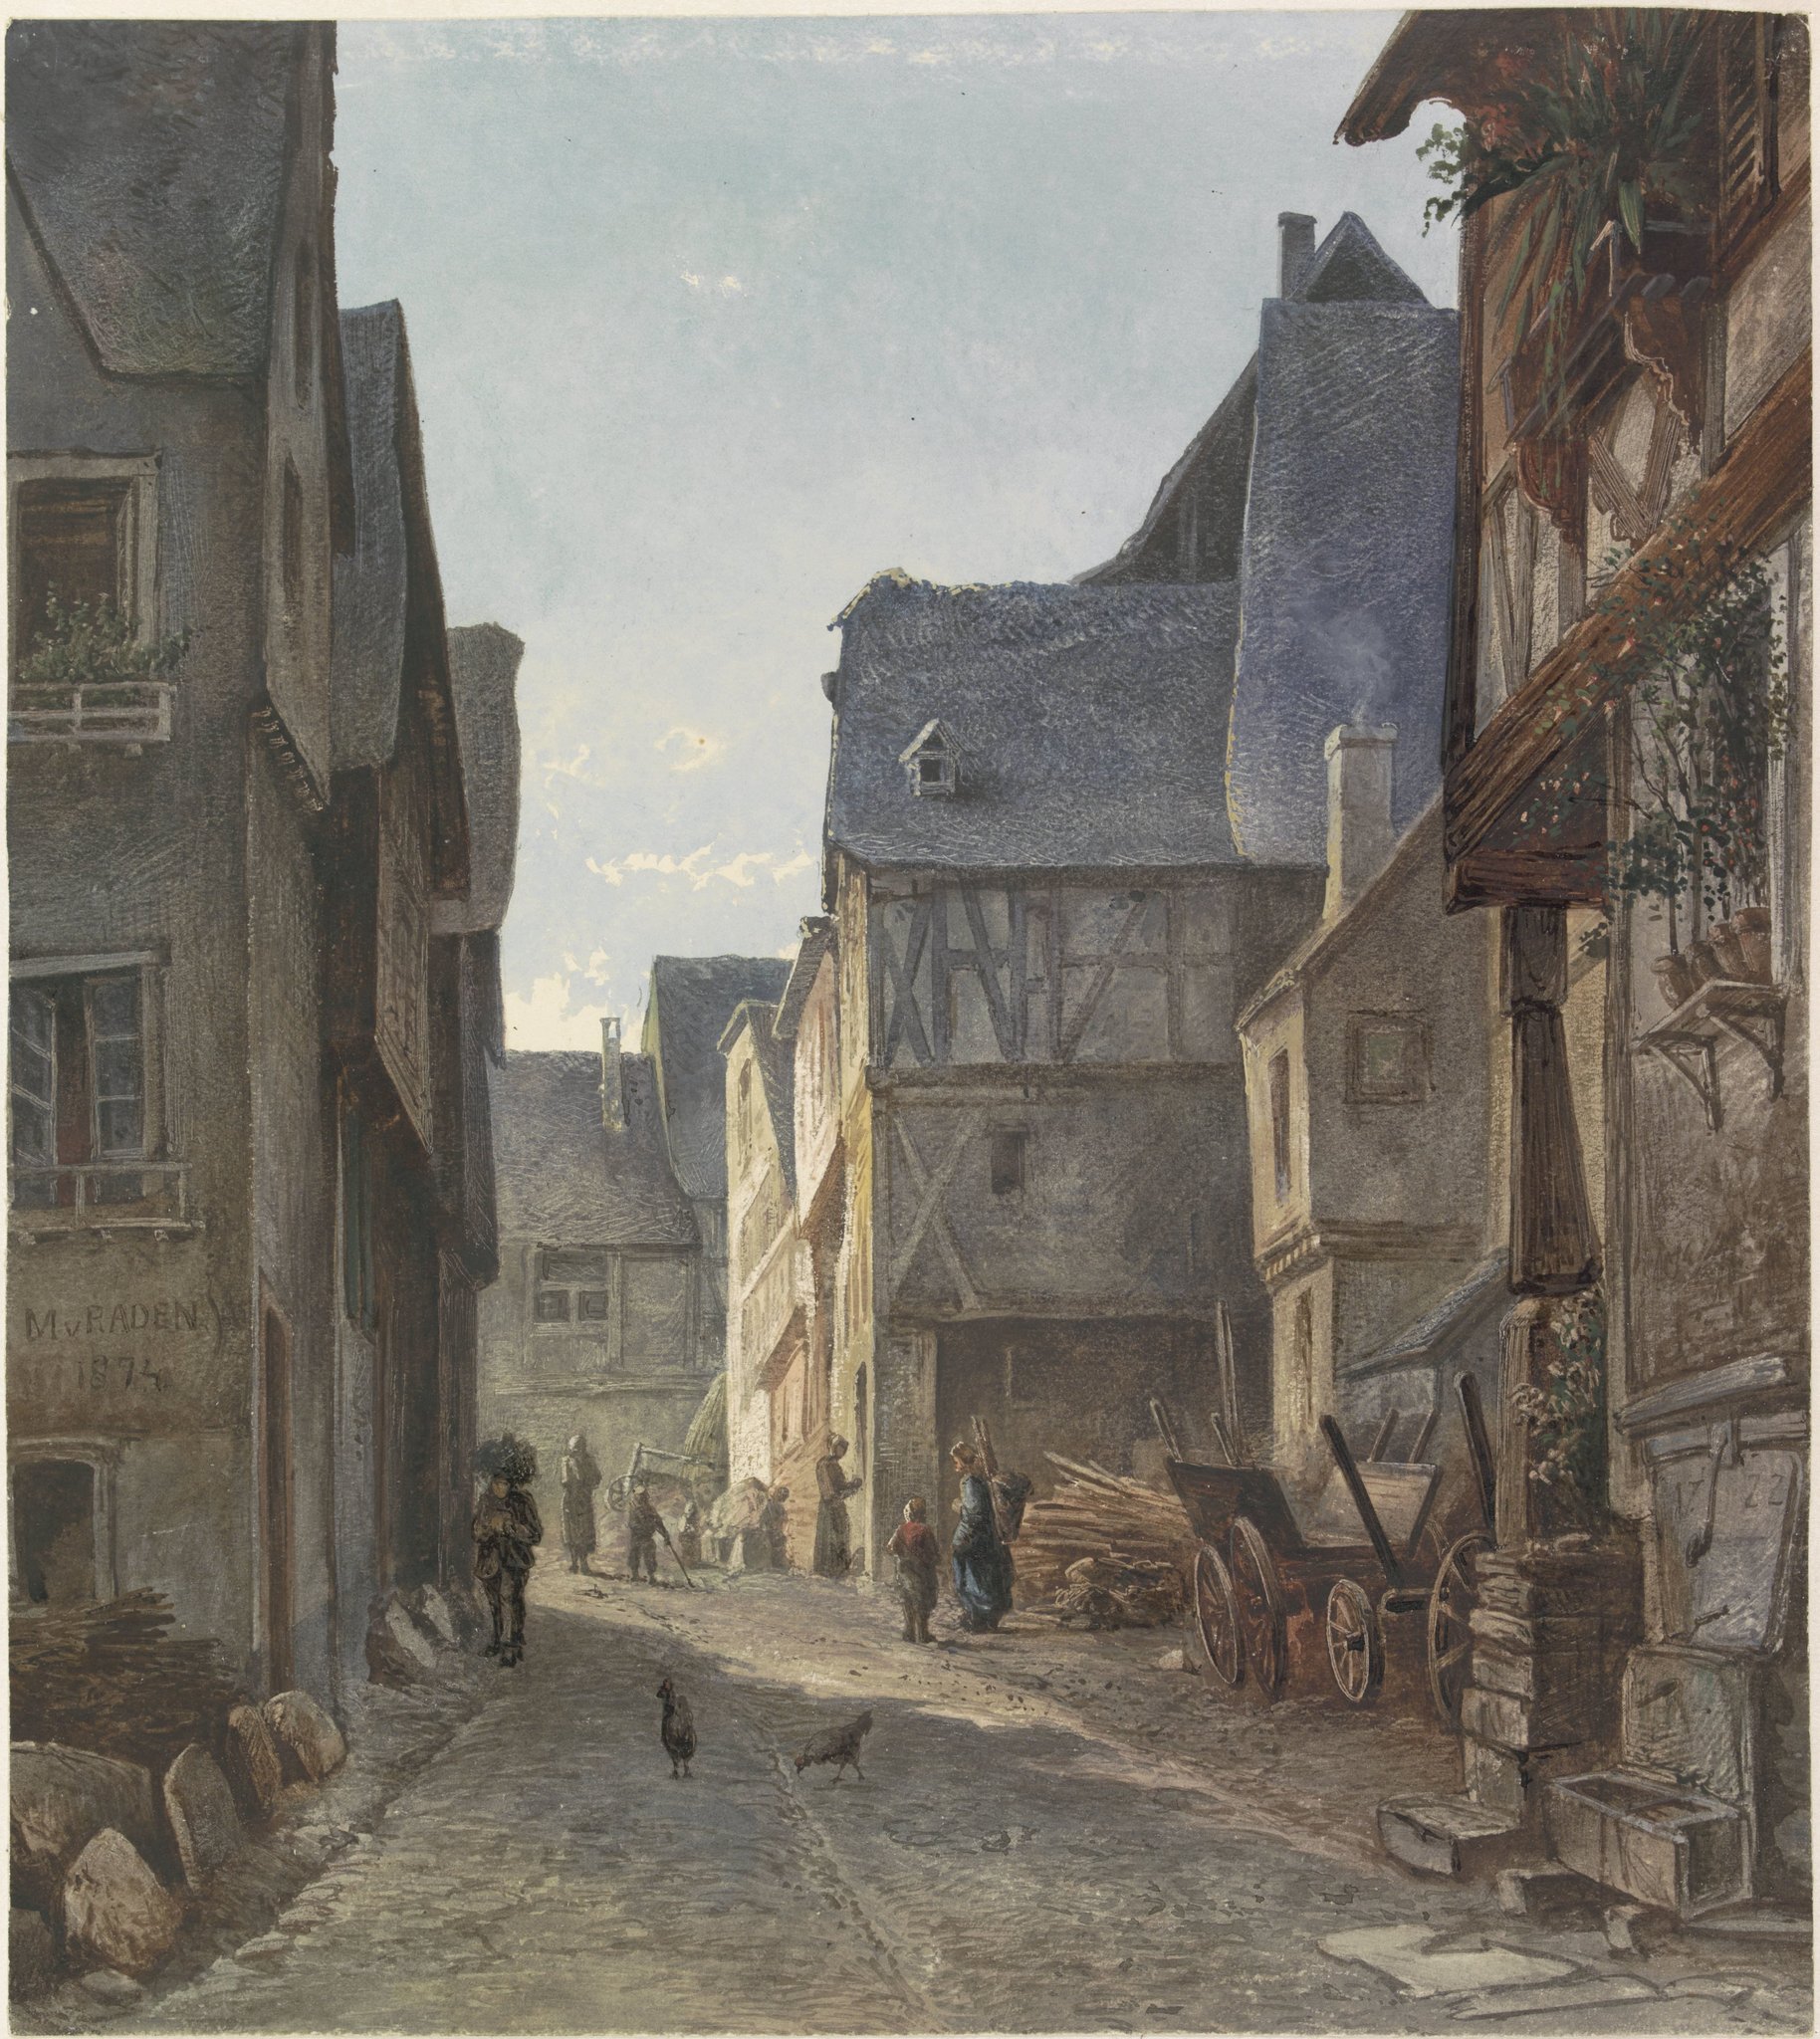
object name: watercolor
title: Gezicht te Pünderich, aan de Mosel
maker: marinus van raden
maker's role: draughtsman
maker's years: 1832-1879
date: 1874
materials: paper, watercolor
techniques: brush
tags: street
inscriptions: date: ‘1874’